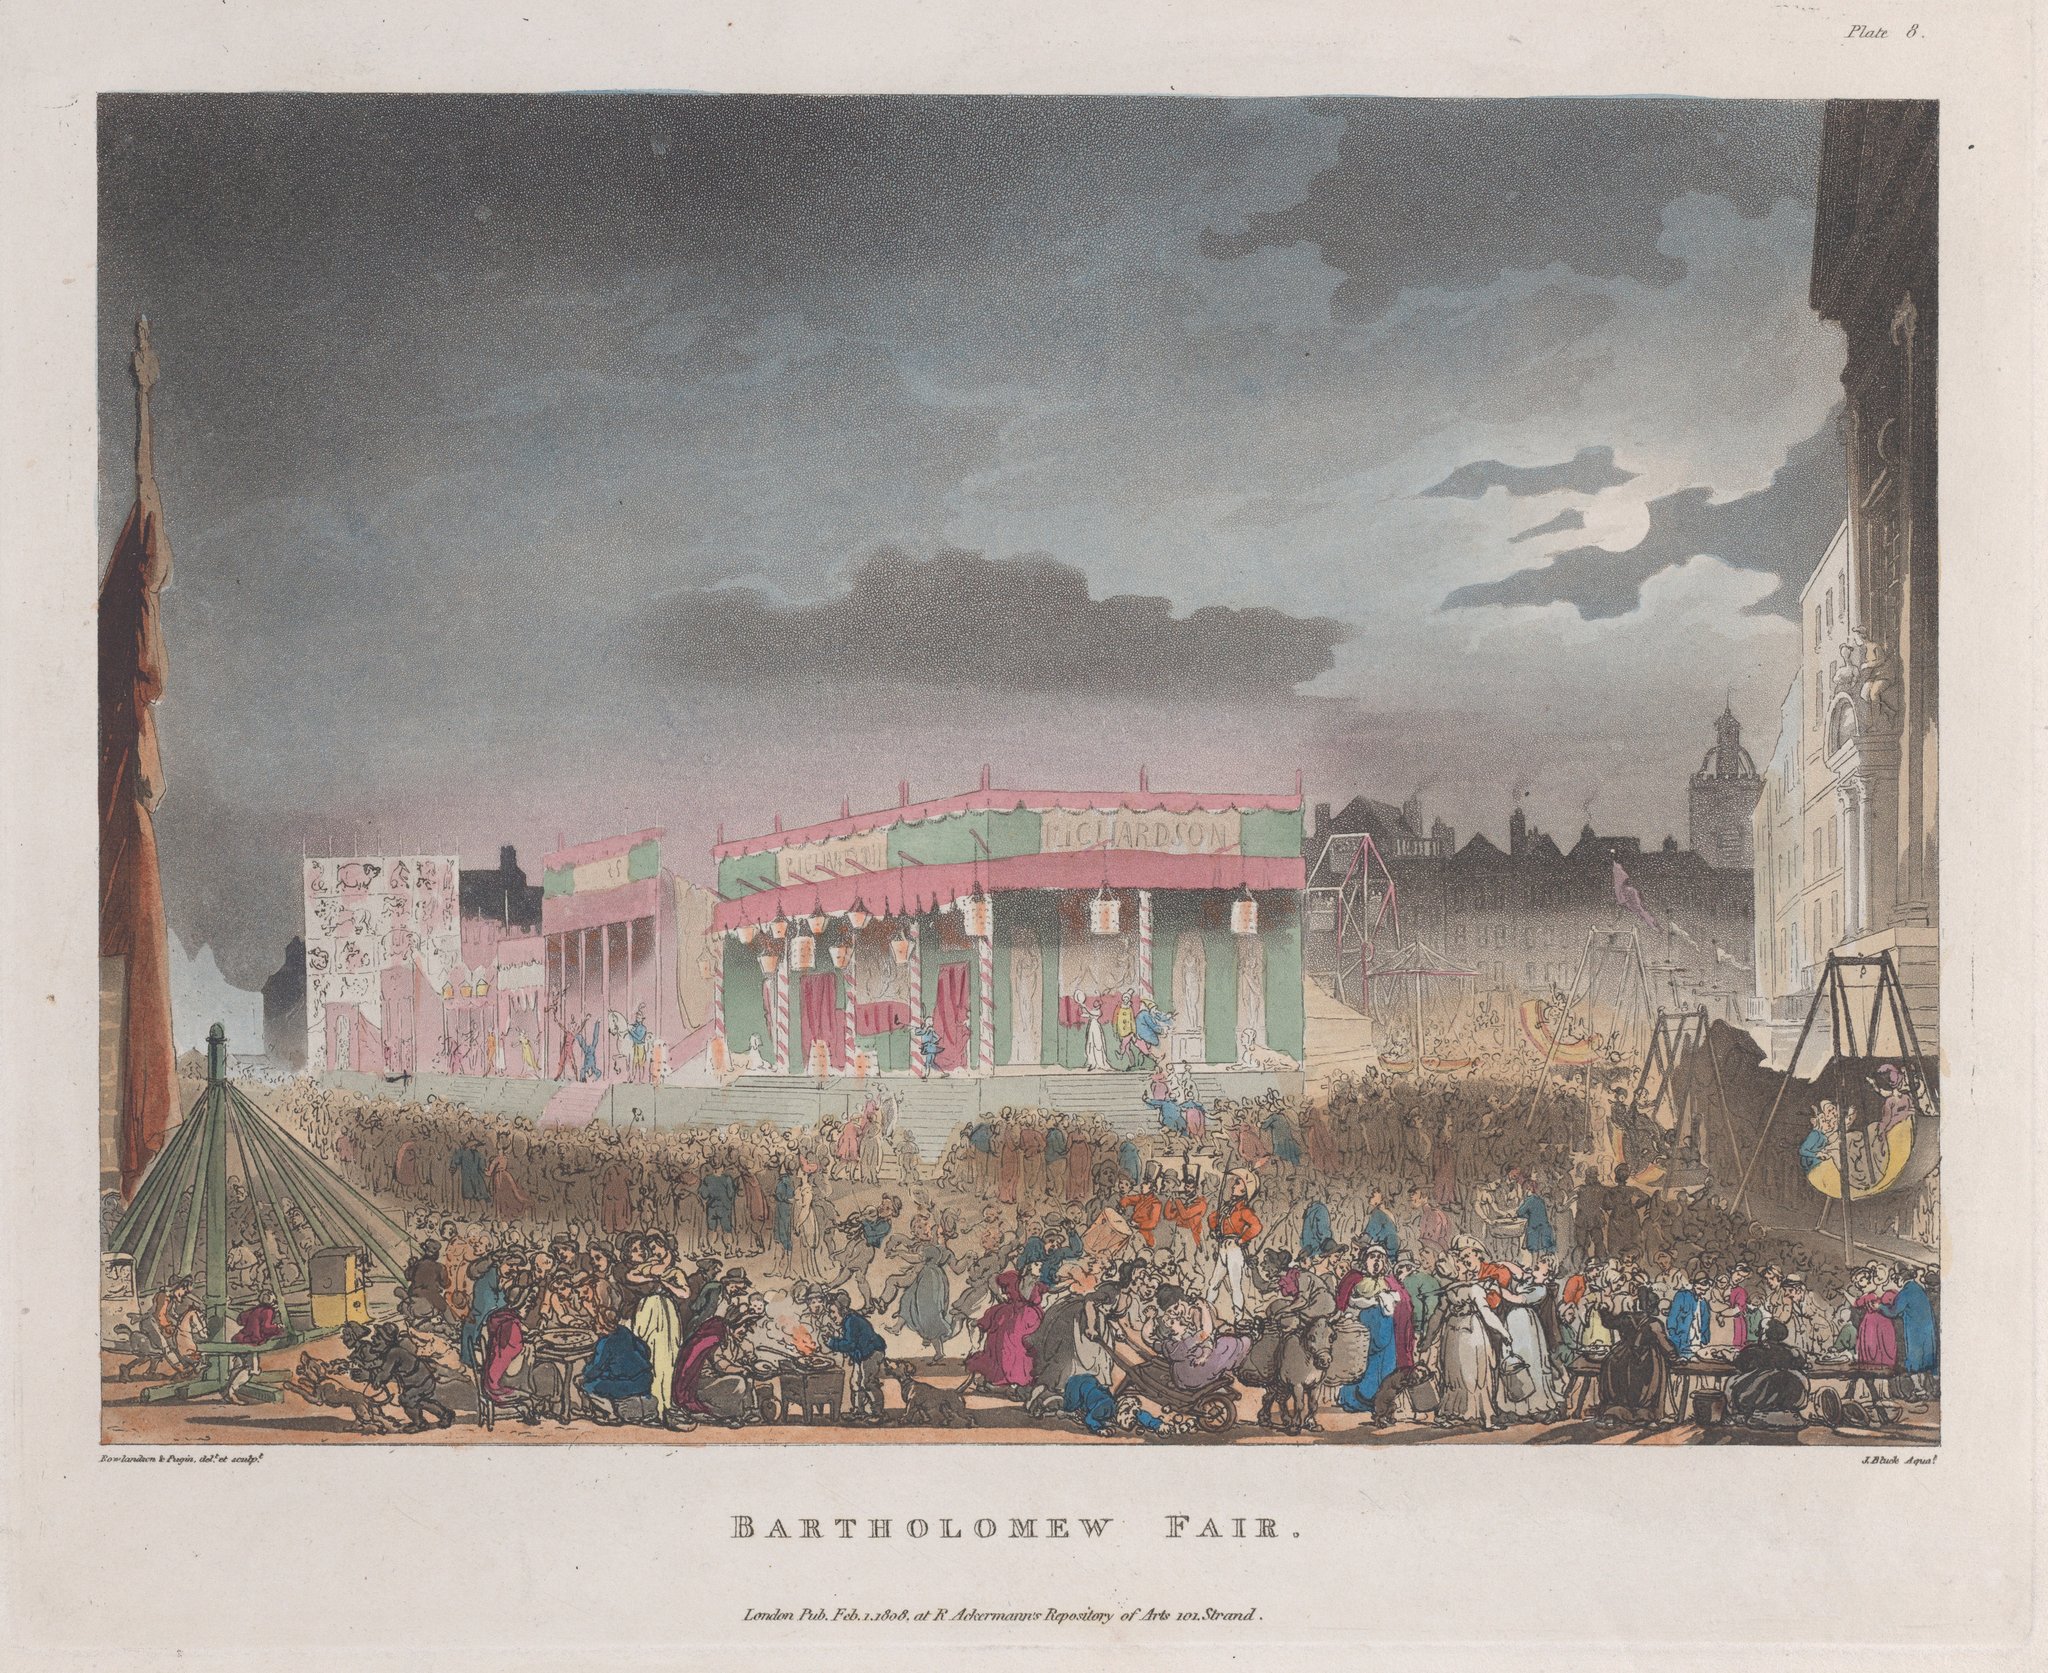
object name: print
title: Bartholomew Fair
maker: thomas rowlandson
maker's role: artist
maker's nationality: british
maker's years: 1757-1827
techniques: aquatint, etching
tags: leisure,crowd,london